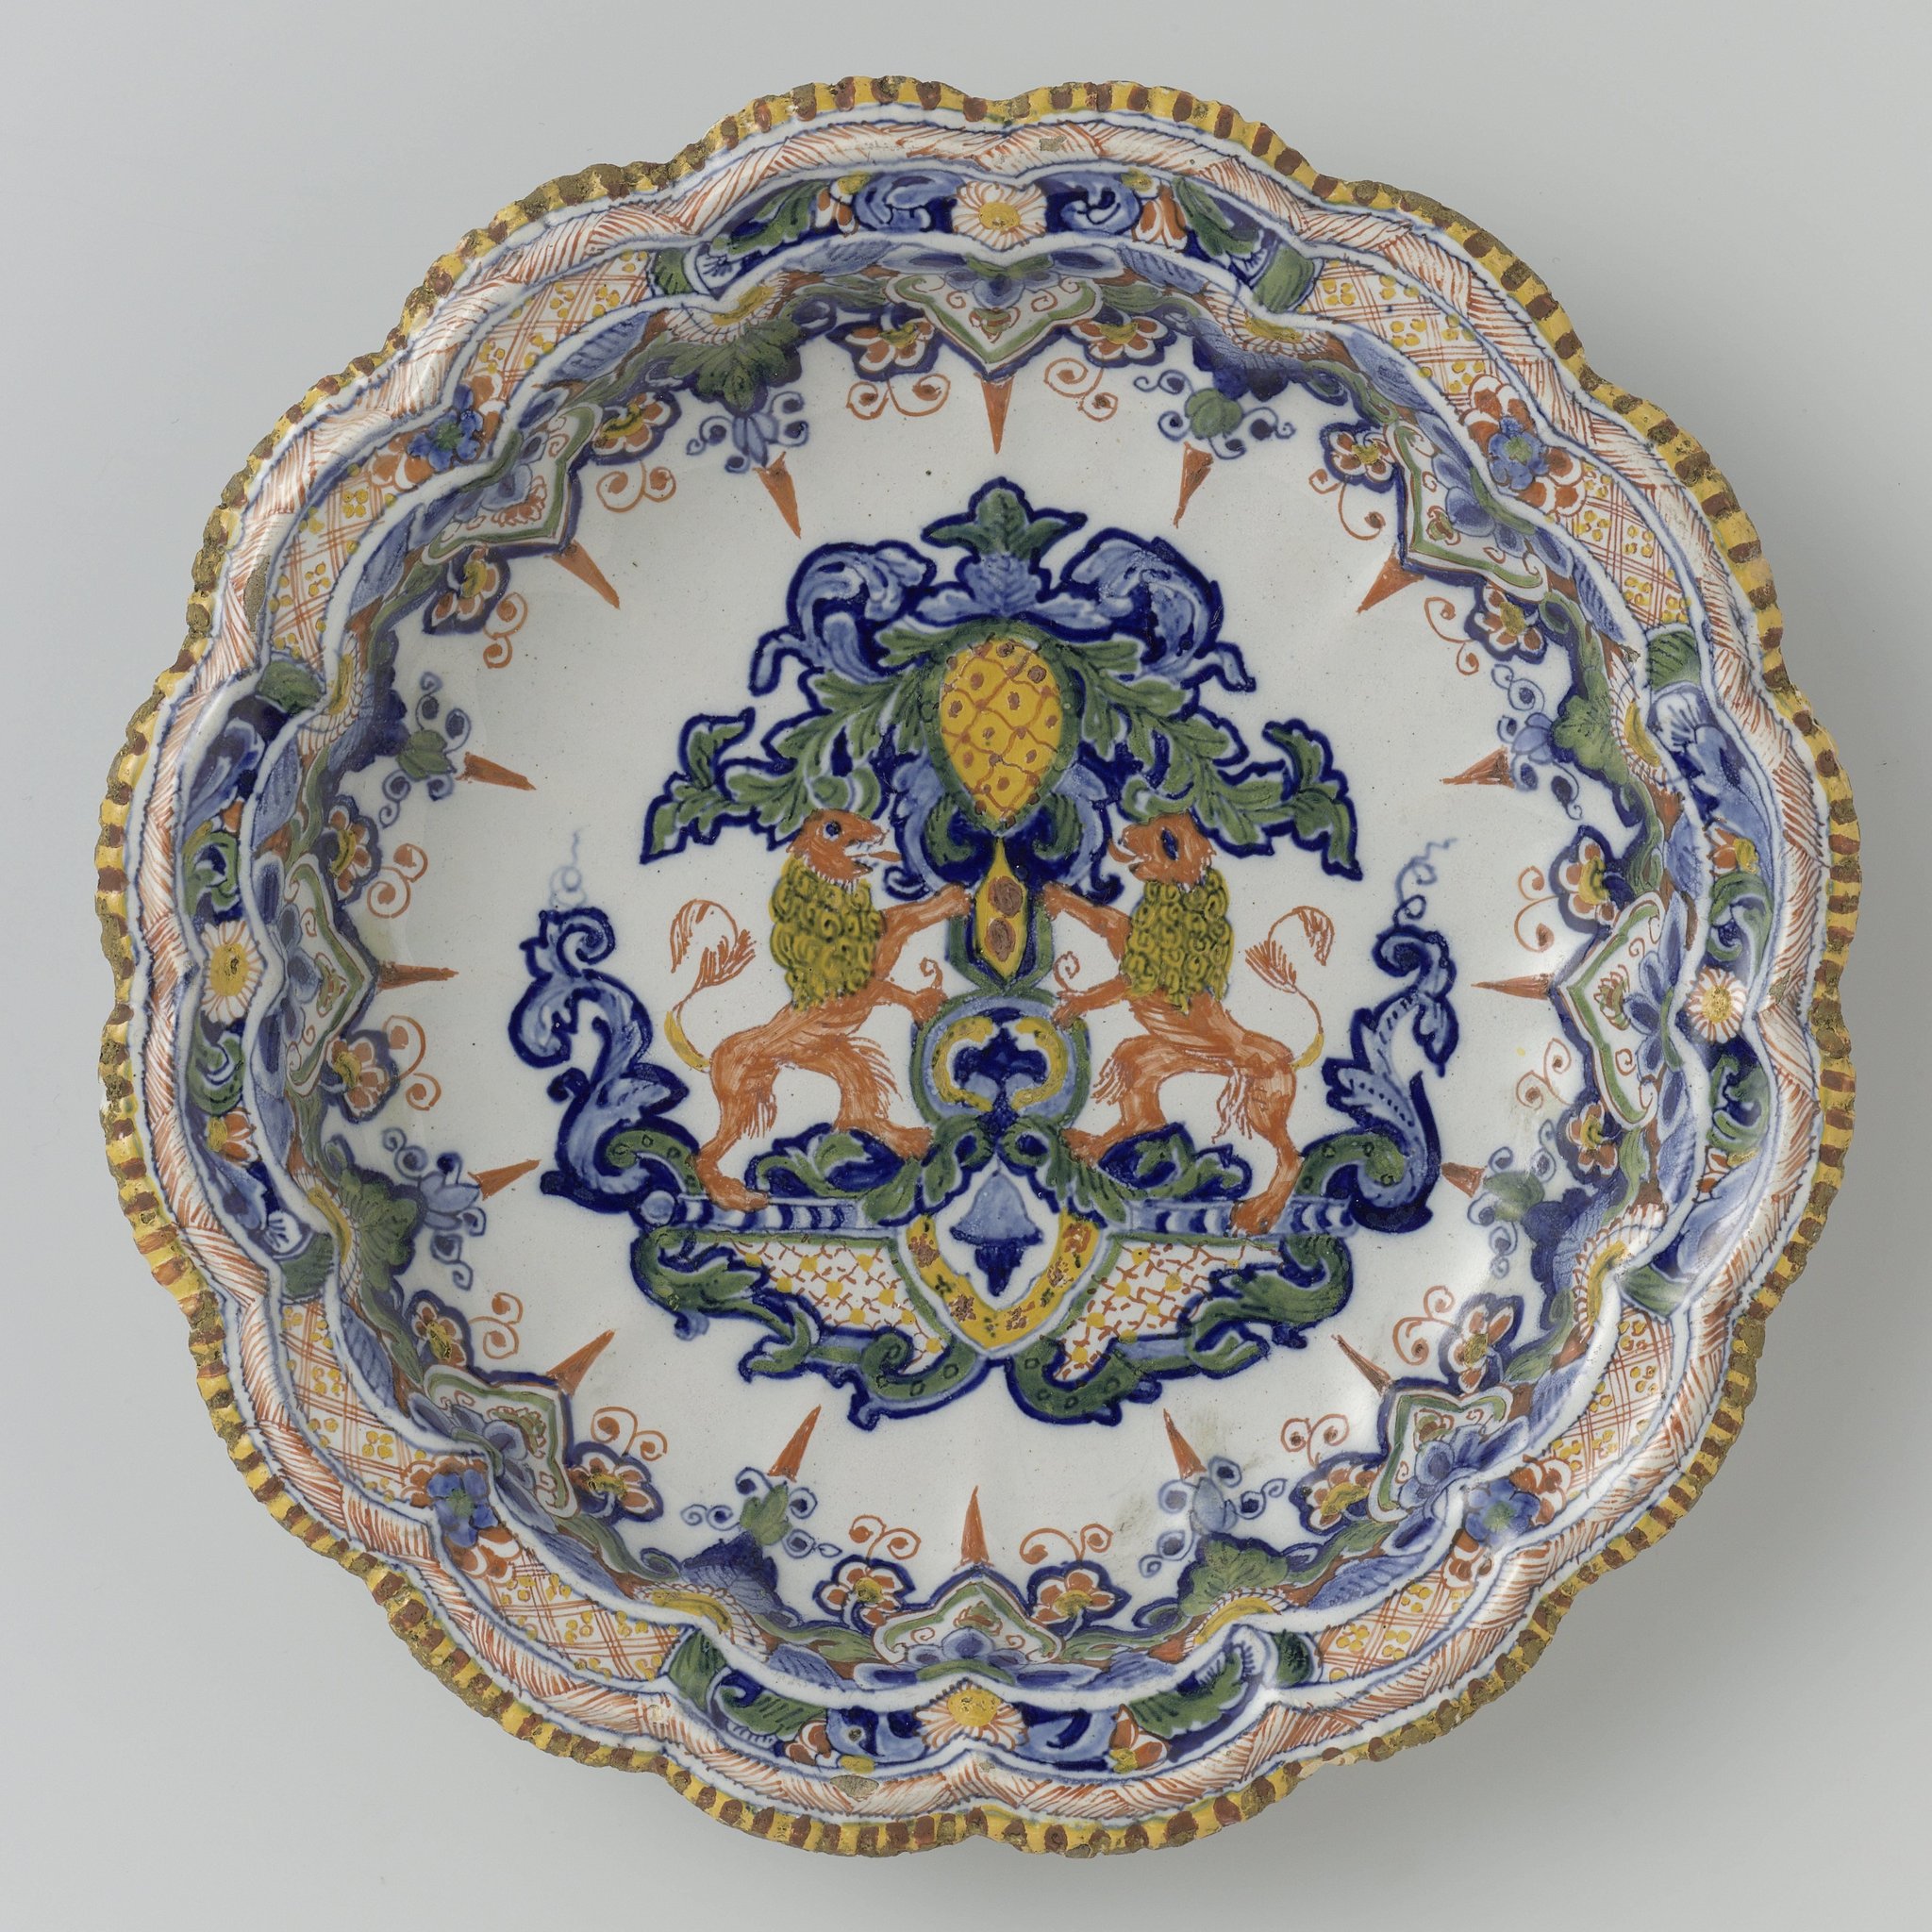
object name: dish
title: Schaal met geschulpte rand; op het plat een heraldisch ornament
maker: Anonymous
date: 1720-1750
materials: faience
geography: delft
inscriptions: collector's mark: ‘collection J.F. Loudon’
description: Schaal met geschulpte rand; op het plat een heraldisch ornament